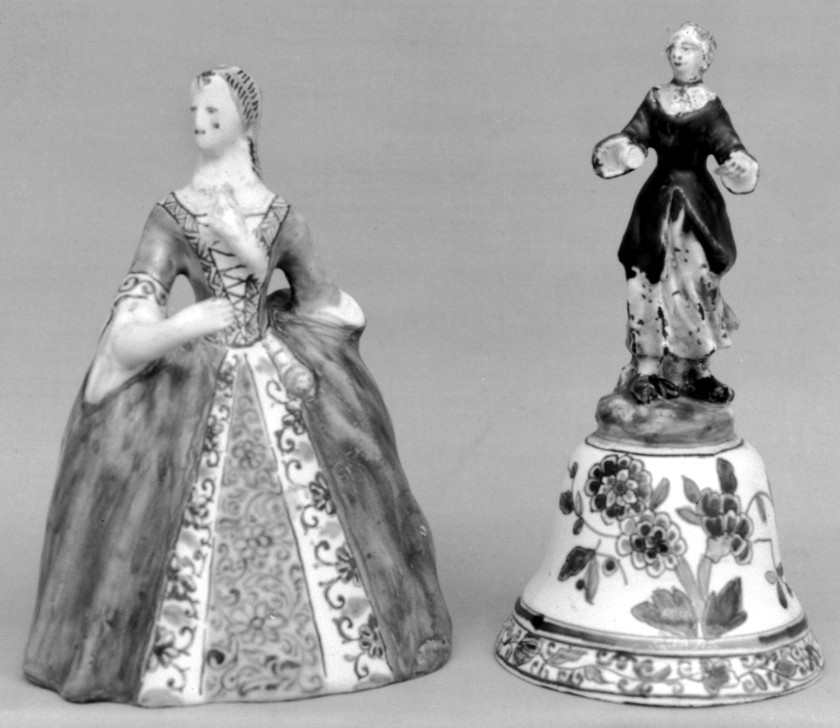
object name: bell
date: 1801-1900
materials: earthenware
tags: women,flowers